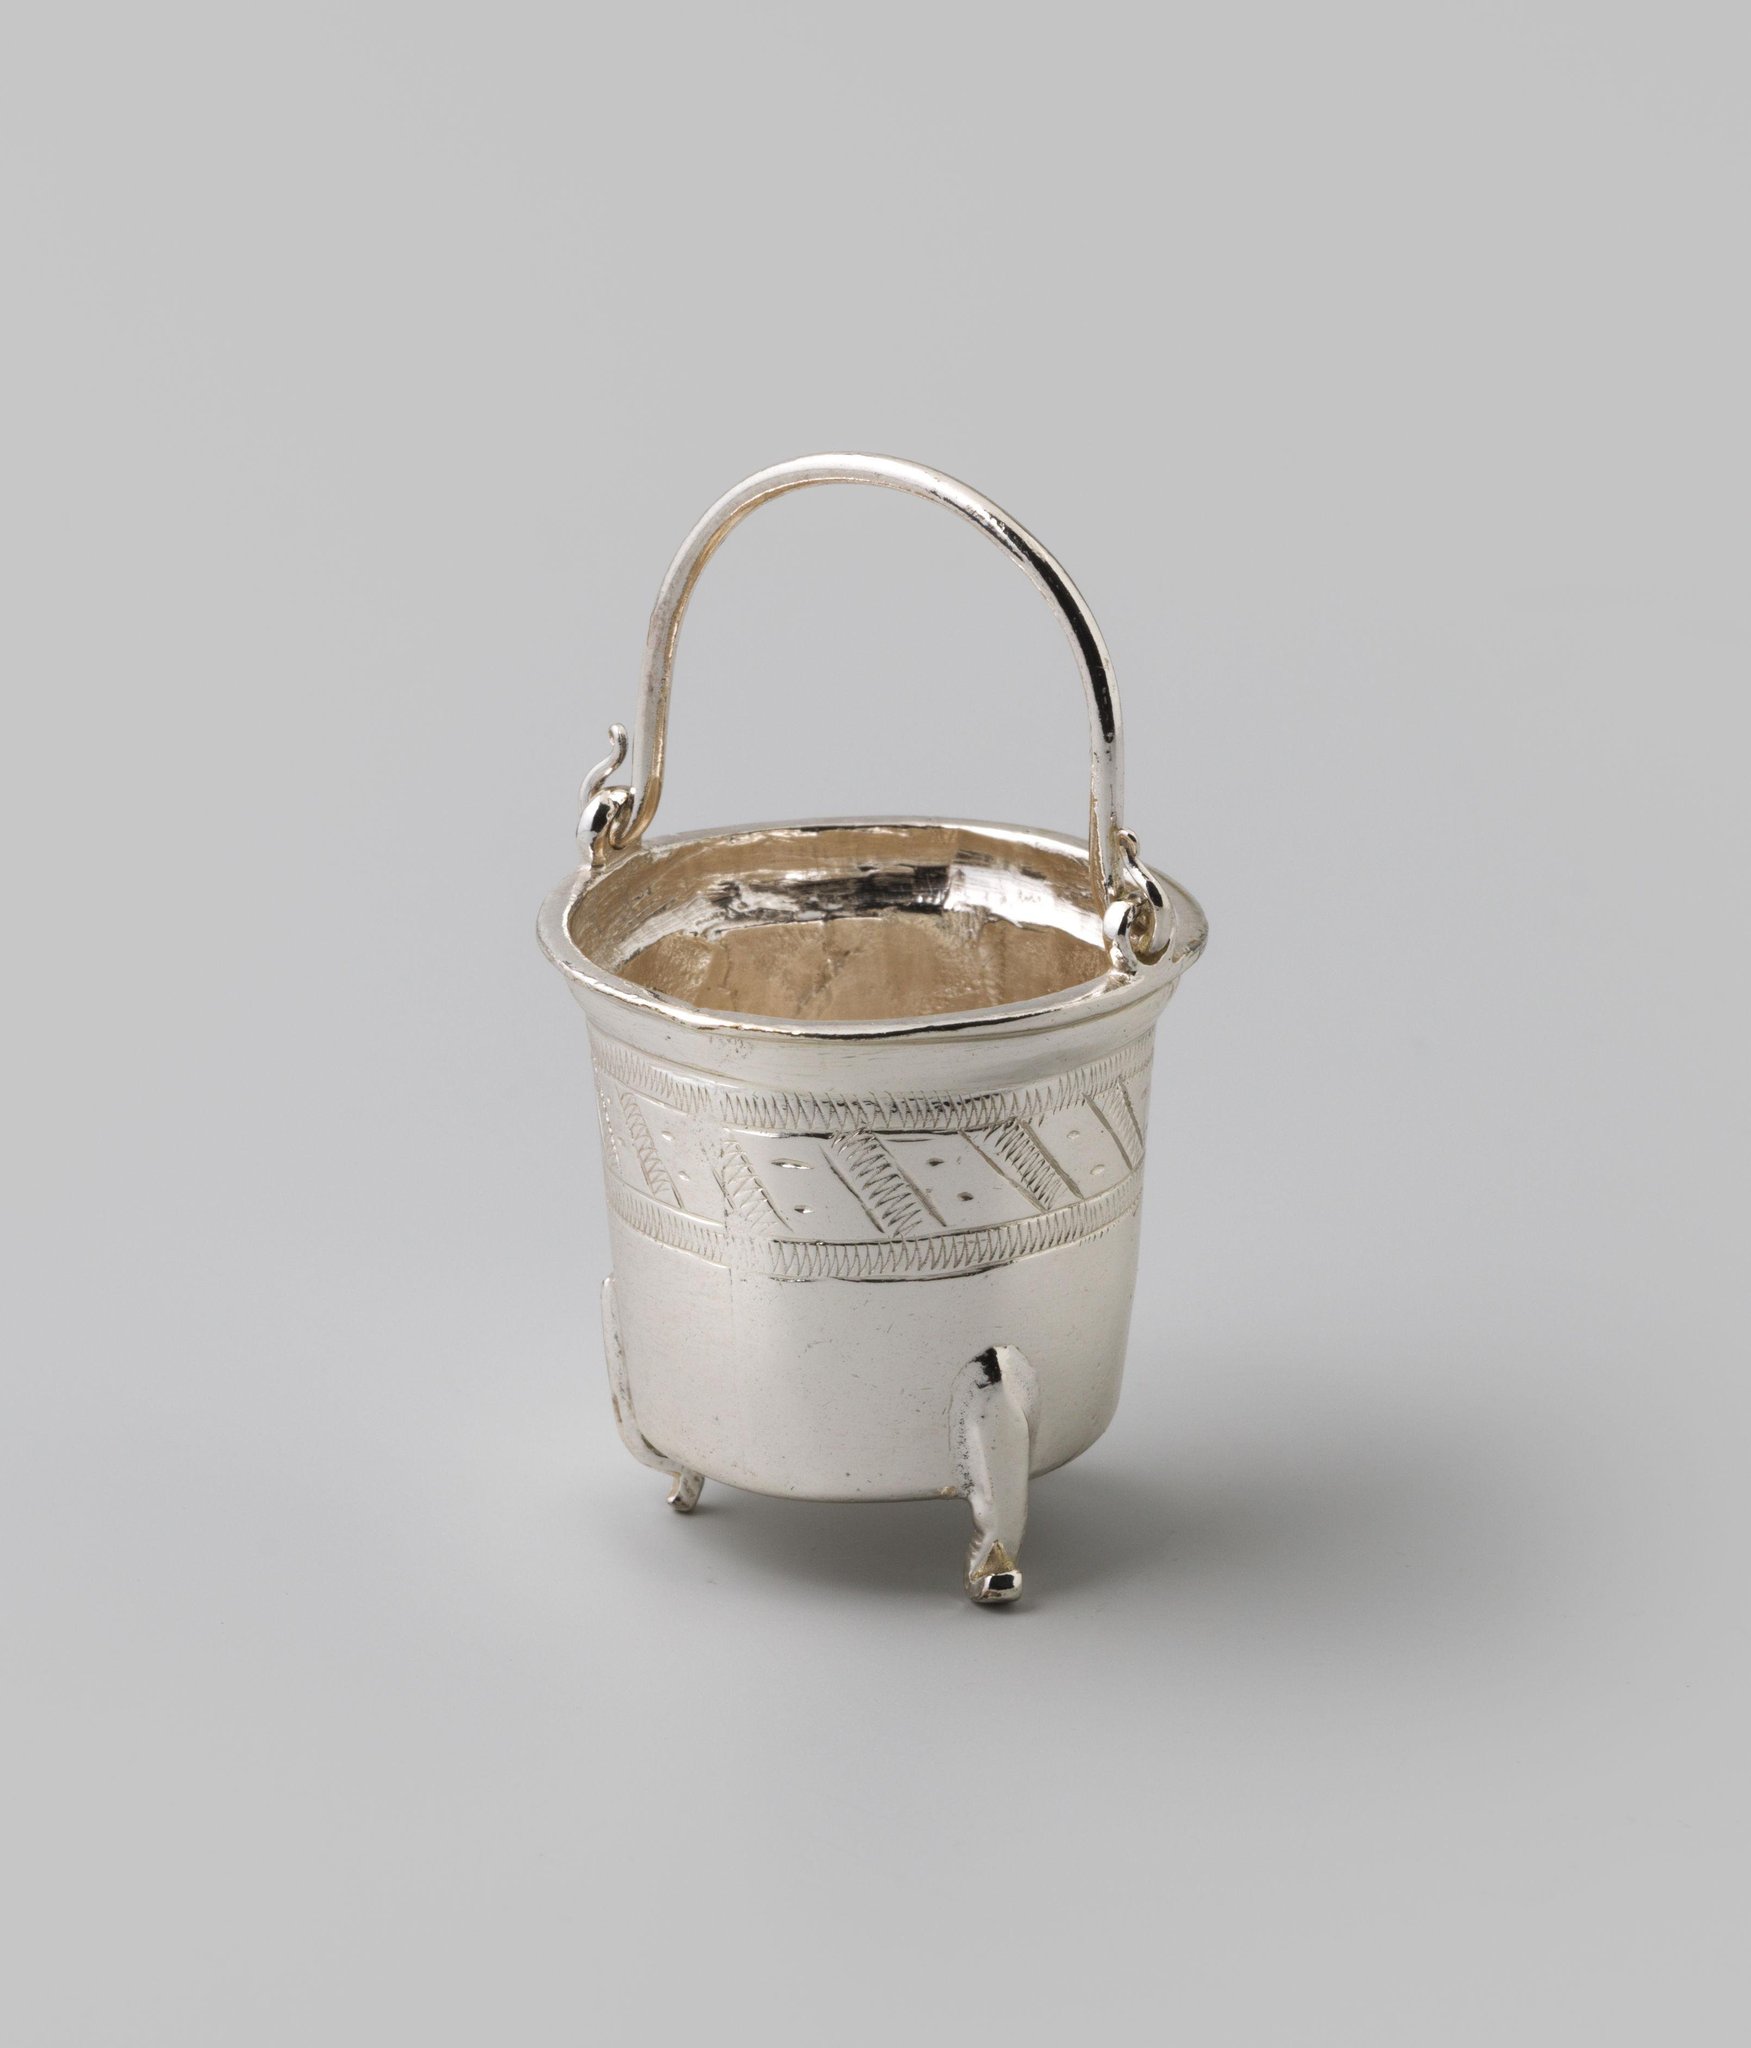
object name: stockpot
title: Kookpan of kookketel van zilver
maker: Anonymous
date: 1675-1725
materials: silver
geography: amsterdam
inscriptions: maker's mark: ‘kop of vuist in rond (Voet 1912, nr. 373; Citroen 1975, nr. 970?)’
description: Kookpot of kookketel van zilver, cilindrisch van vorm, op drie hoge poten met bladversiering, vastgezet op de bak, met gegraveerde versiering van brede rand met schuine banden (trembleerlijnen), scharnierend hengsel.